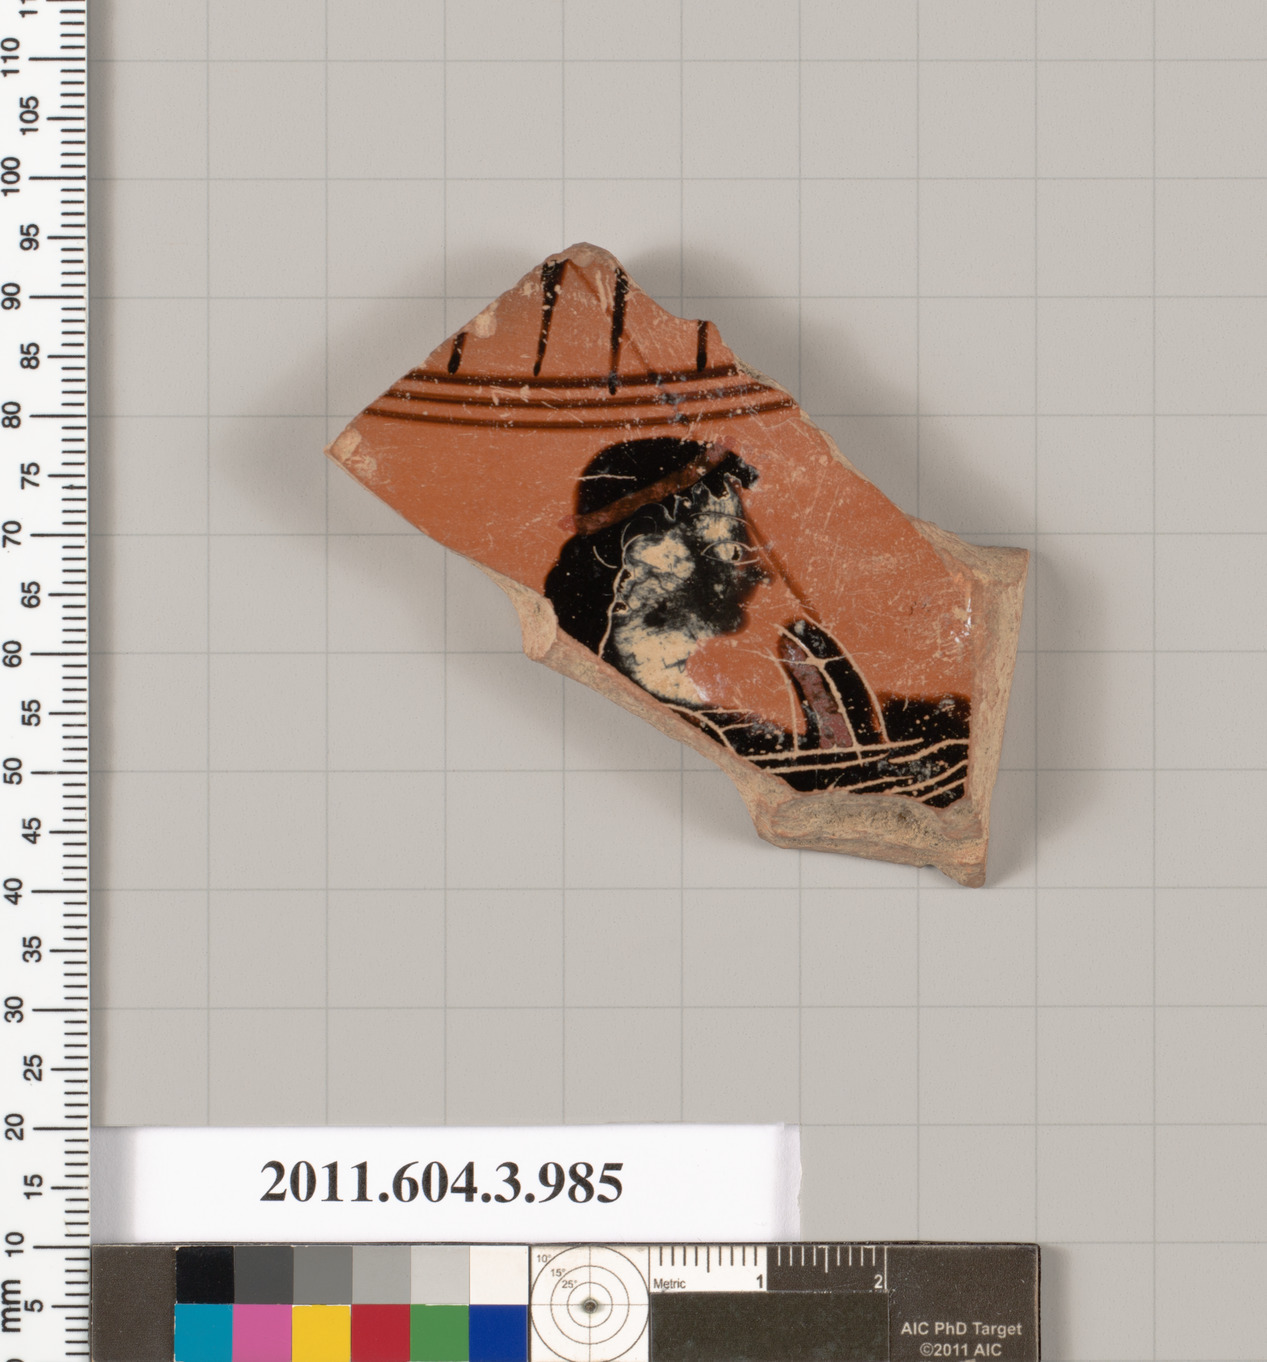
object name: lekanis lid fragment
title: Terracotta fragment of a lekanis lid (covered dish)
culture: greek, attic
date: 575-551 BCE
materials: terracotta